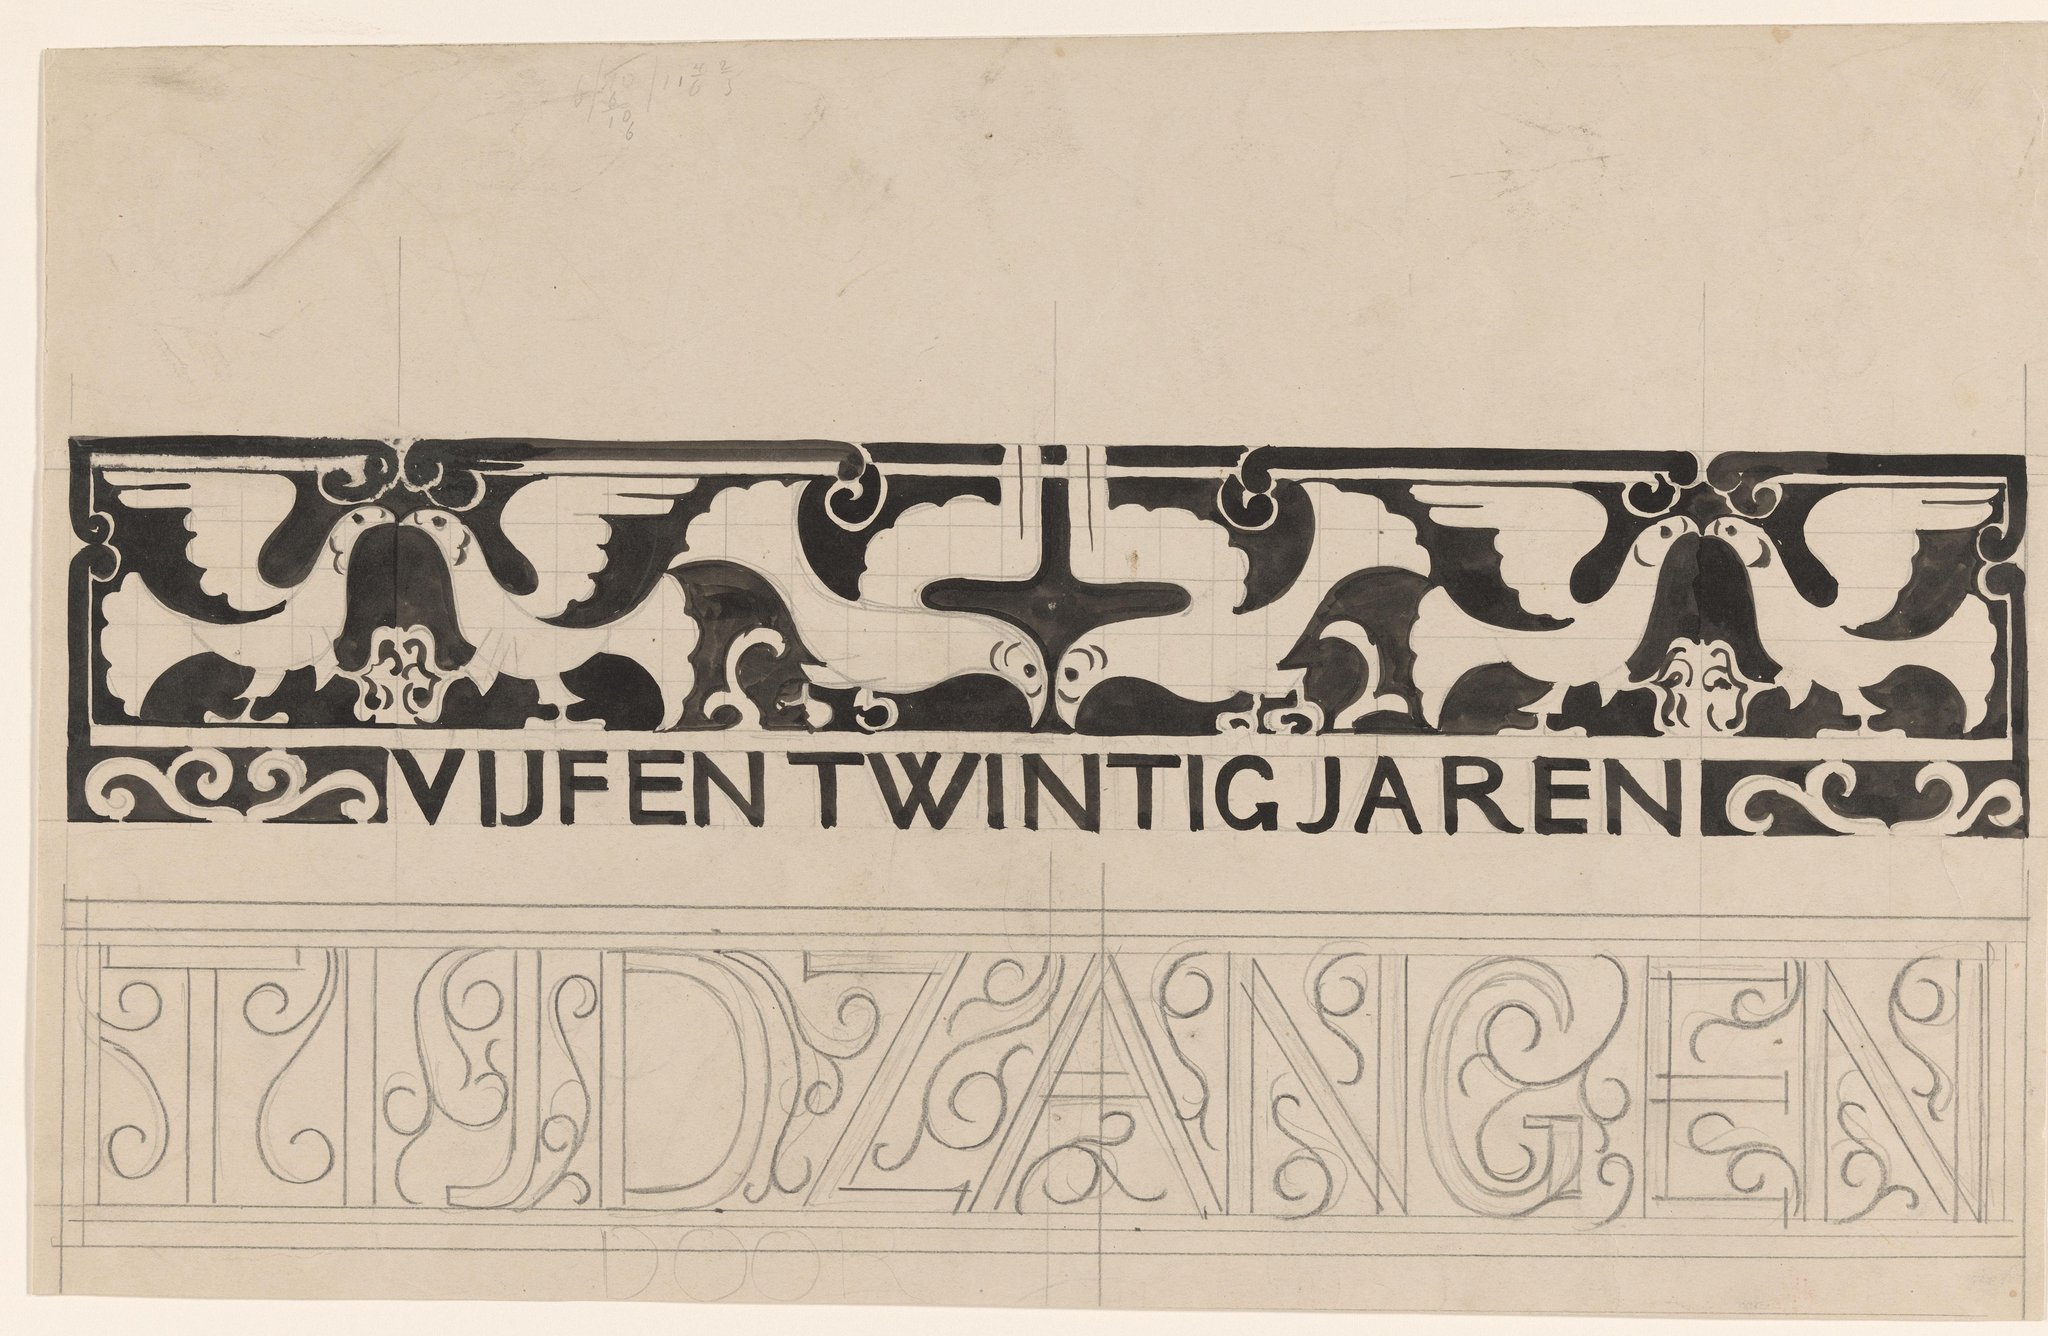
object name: drawing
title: Ontwerp voor decoratie van het gedenkboek voor koningin Wihelmina uit 1923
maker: carel adolph lion cachet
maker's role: draughtsman, print maker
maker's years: 1864-1945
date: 1874-1945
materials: paper, pencil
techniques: brush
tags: other ornament derived from animal forms - aa - stylized, birds